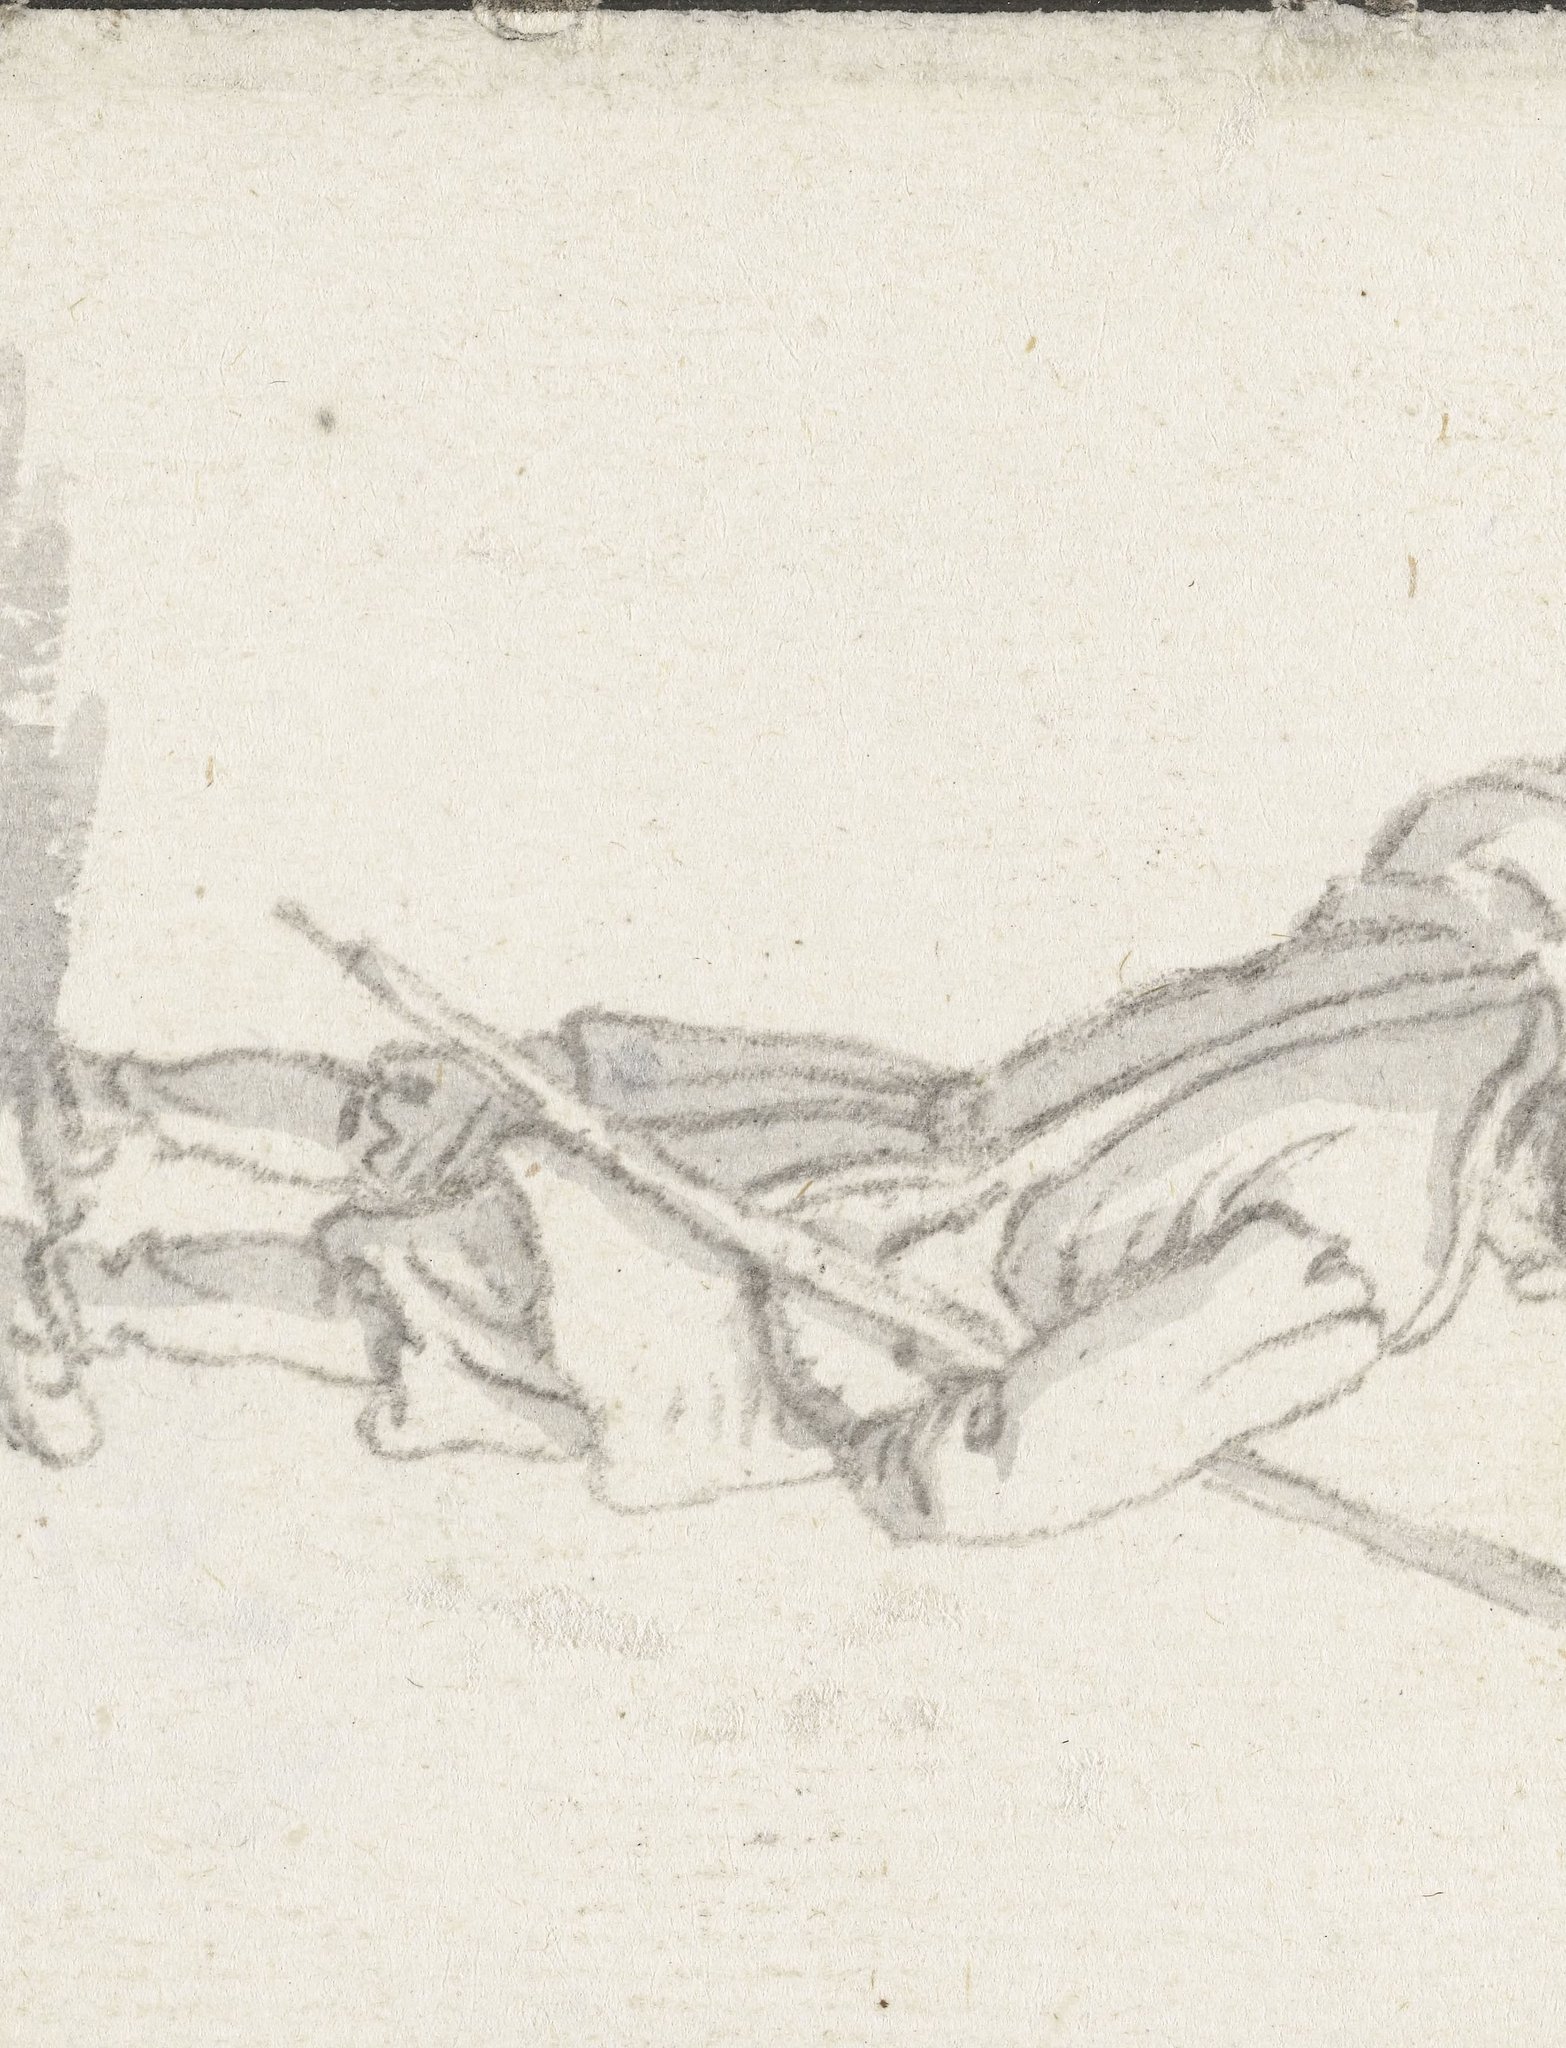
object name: drawing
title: Staande man met een stok onder de arm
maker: herman saftleven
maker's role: draughtsman, painter, print maker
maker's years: 1609-1685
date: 1619-1685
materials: chalk, paper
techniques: brush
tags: standing figure